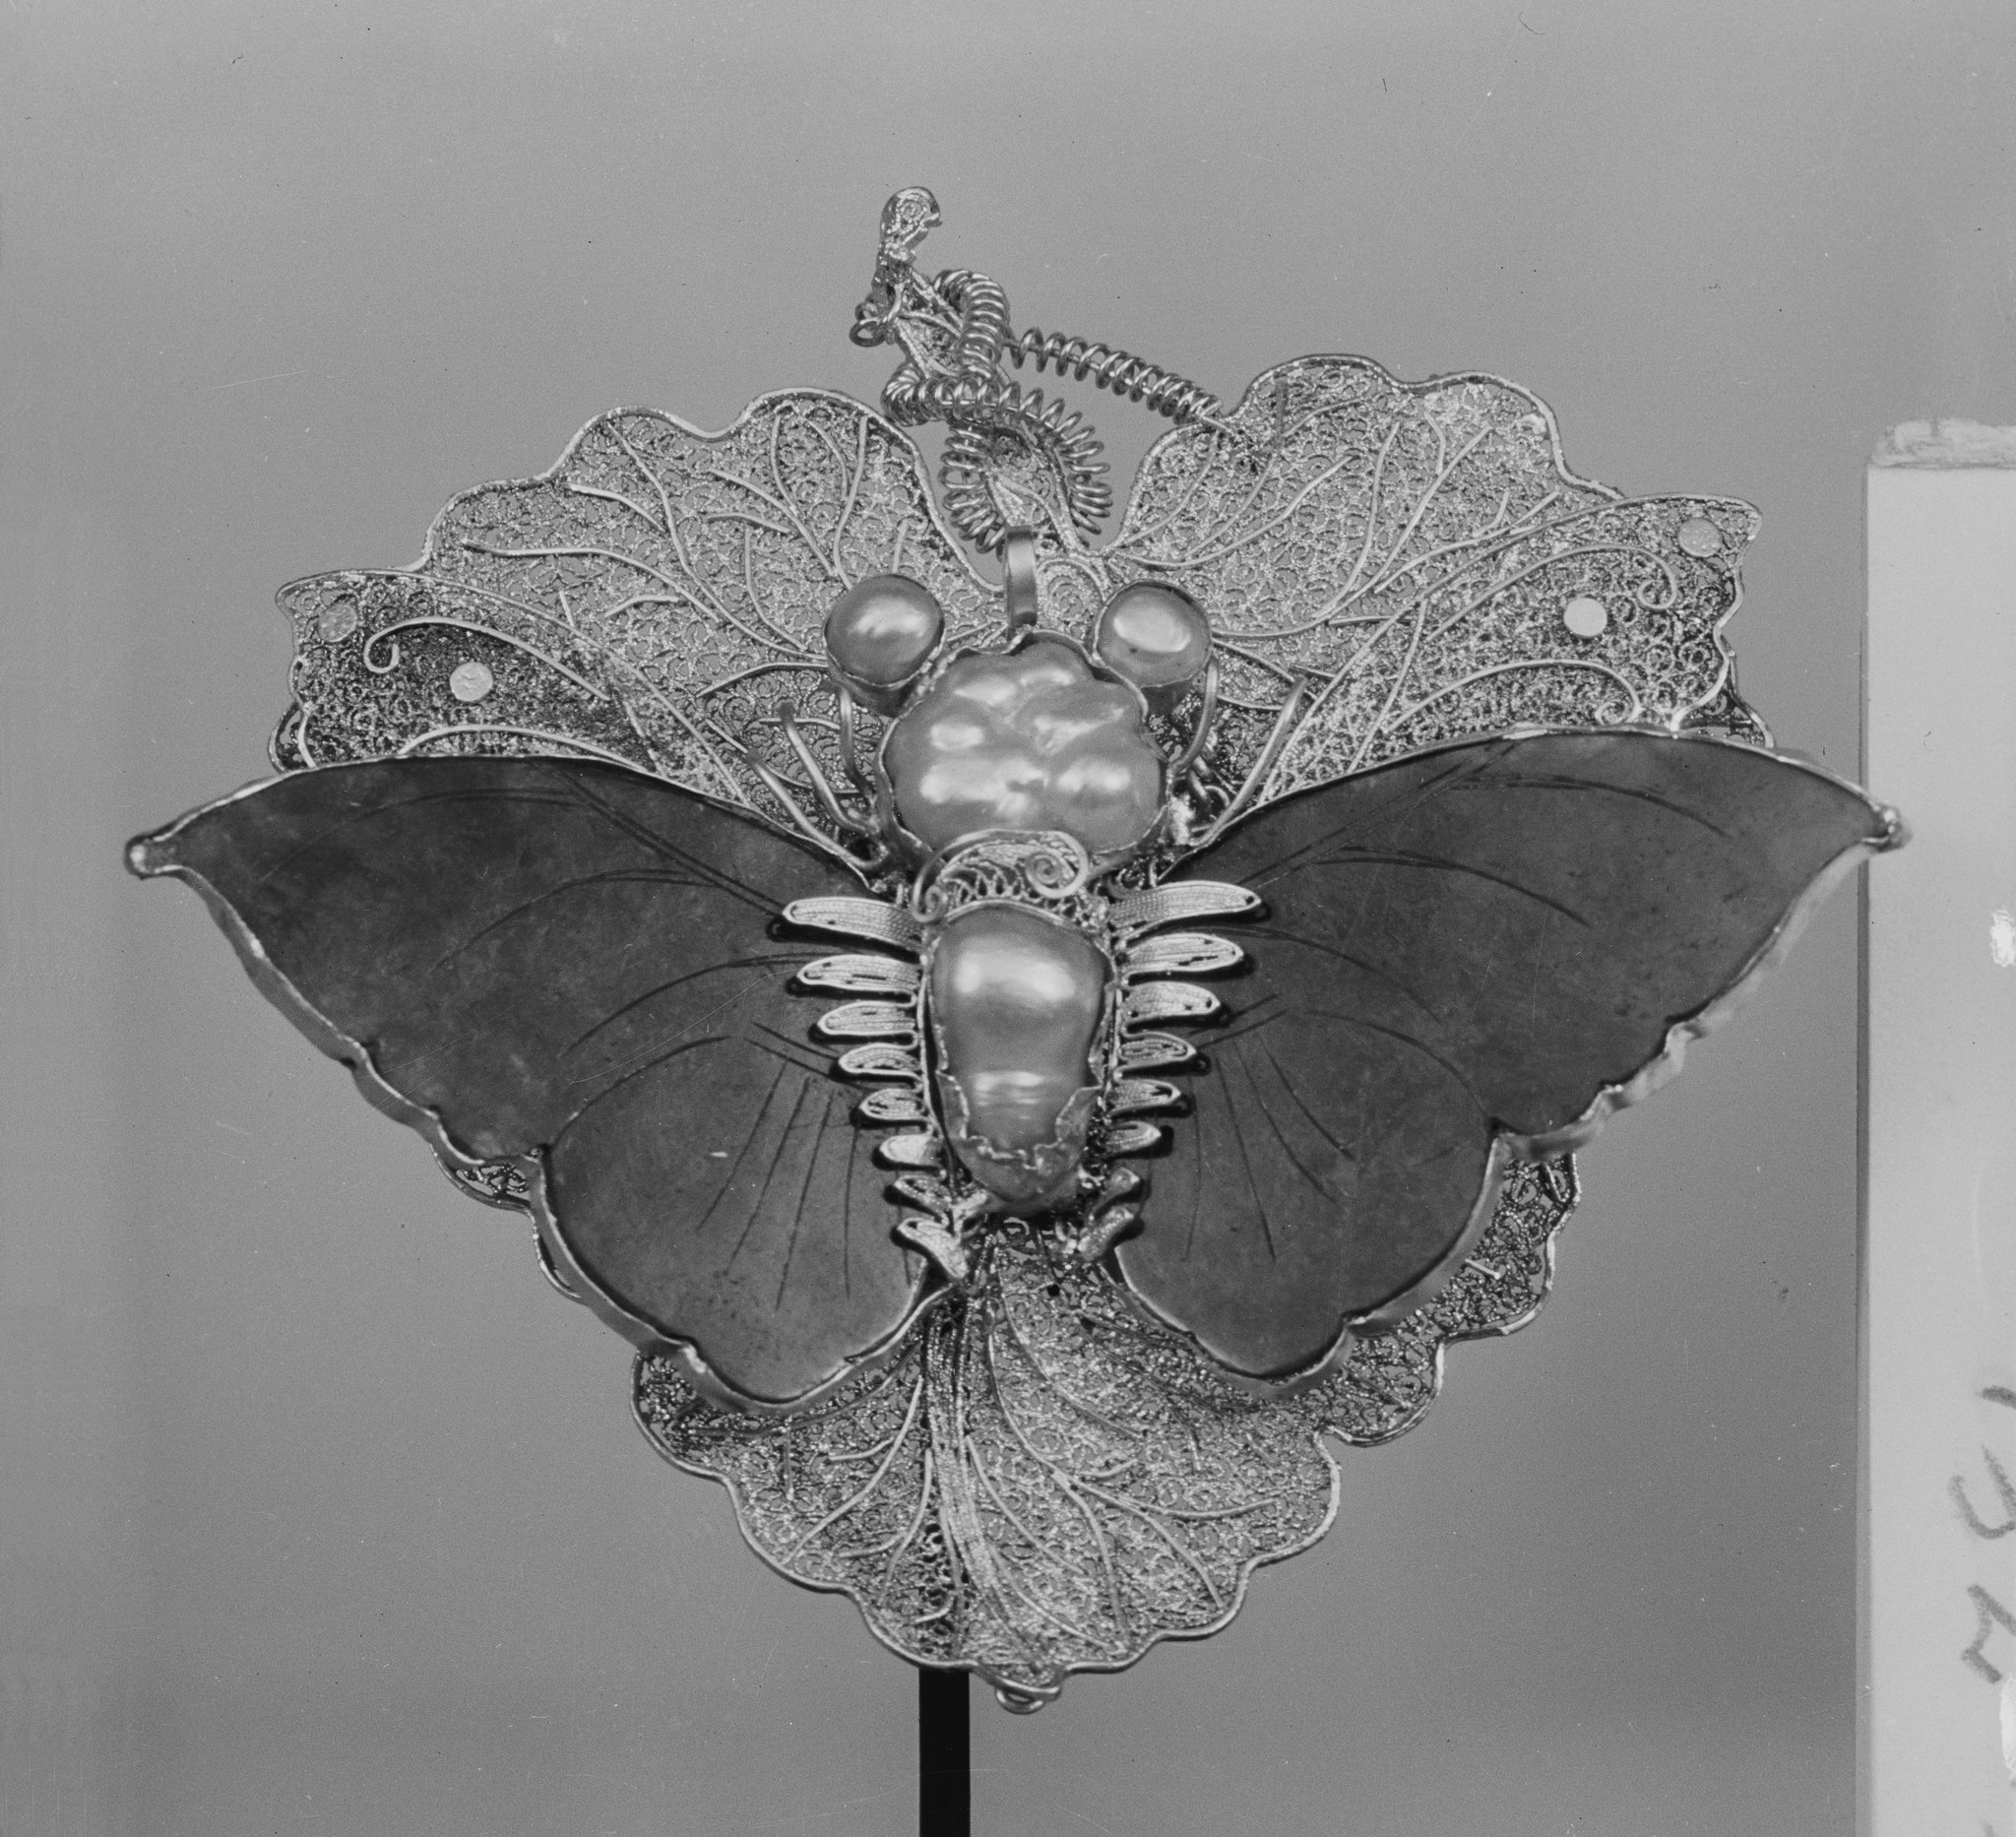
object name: figure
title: Butterfly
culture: chinese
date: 1701-1800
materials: gold, jade, pearl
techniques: filigree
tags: butterflies,leaves